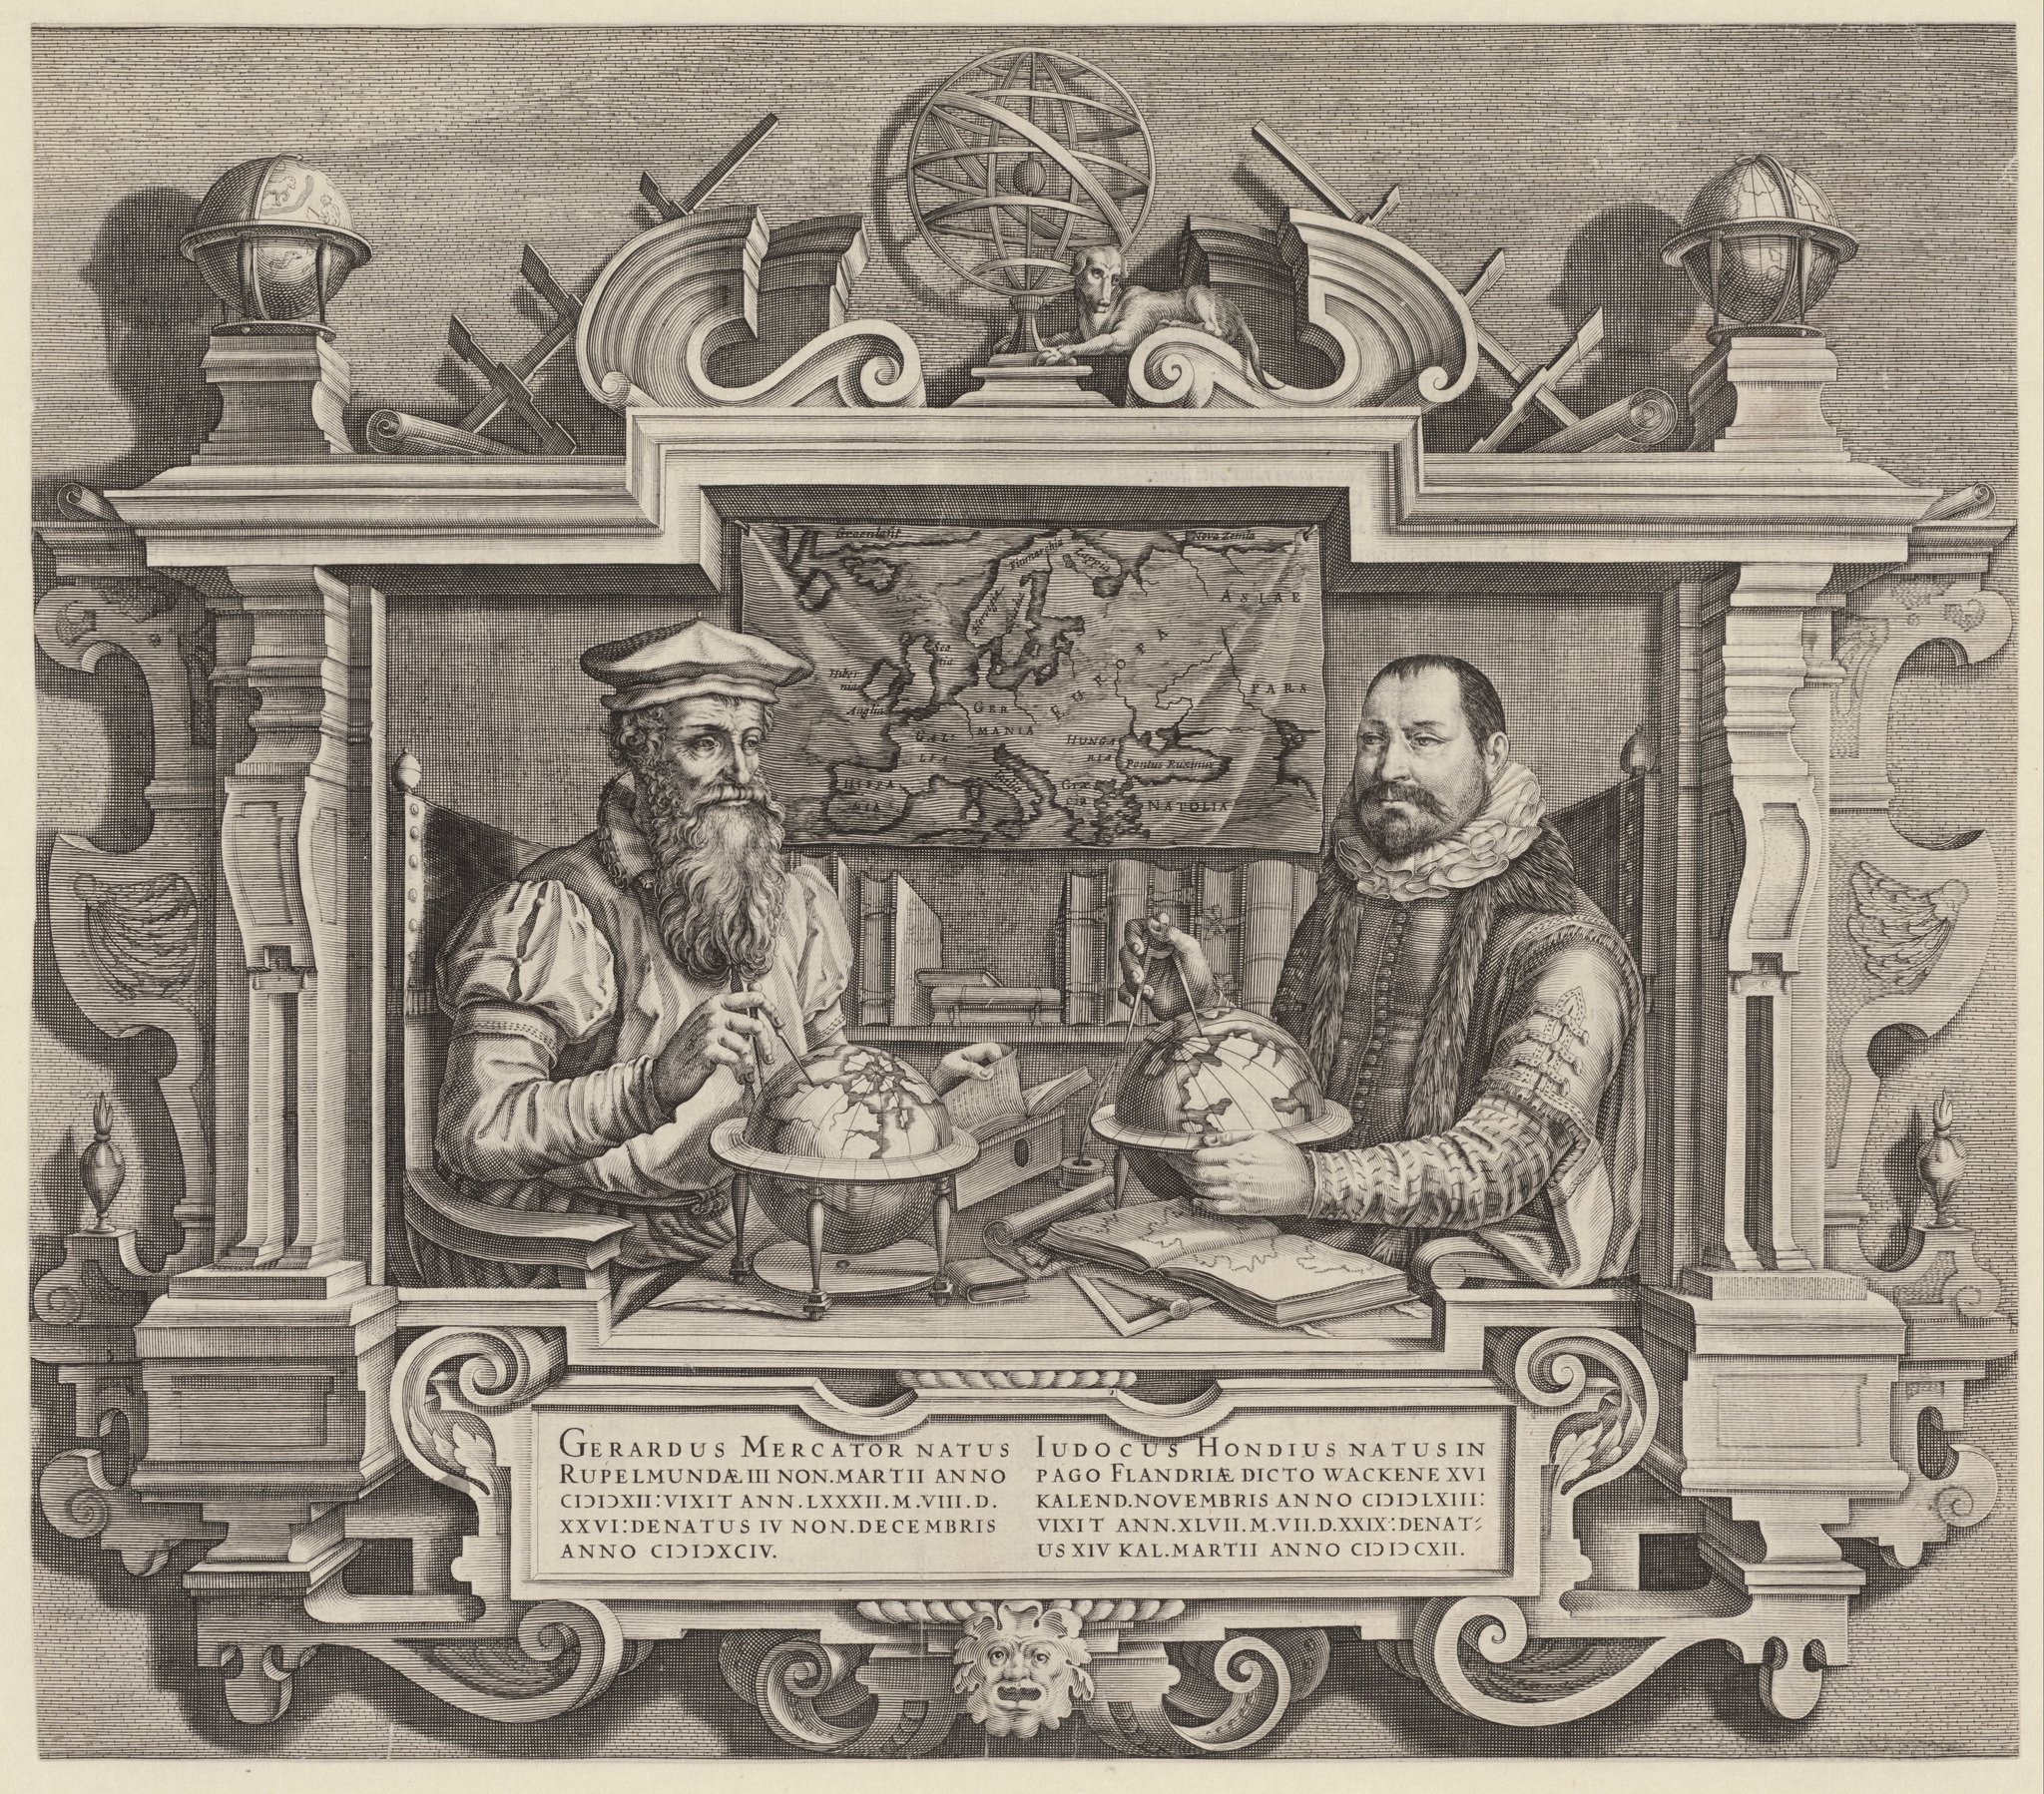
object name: print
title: Portret van Jodocus Hondius en Gerard Mercator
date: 1613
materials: paper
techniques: engraving, letterpress printing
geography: amsterdam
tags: jodocus hondius, instrument maker, gerardus mercator, maps, atlases, historical persons, science and technology (+ portrait of scholar, scientist), globe, star-globe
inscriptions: collector's mark: Lugt 2228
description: De geleerden en cartografen Gerard Mercator (1512-1594) en Jodocus Hondius (1563-1612) zijn samen afgebeeld te midden van hun instrumenten die te maken hebben met hun vak. Beiden hebben landkaarten en hemel- en wereldglobes vervaardigd en astronomische instrumenten geconstrueerd. Het portret verscheen in 1613 in Mercator's 'Atlas', bij Jodocus Hondius uitgegeven in Amsterdam. Het is lange tijd toegeschreven geweest aan de graveur Hendrick Hondius, maar deze toeschrijving is in 1994 verworpen.